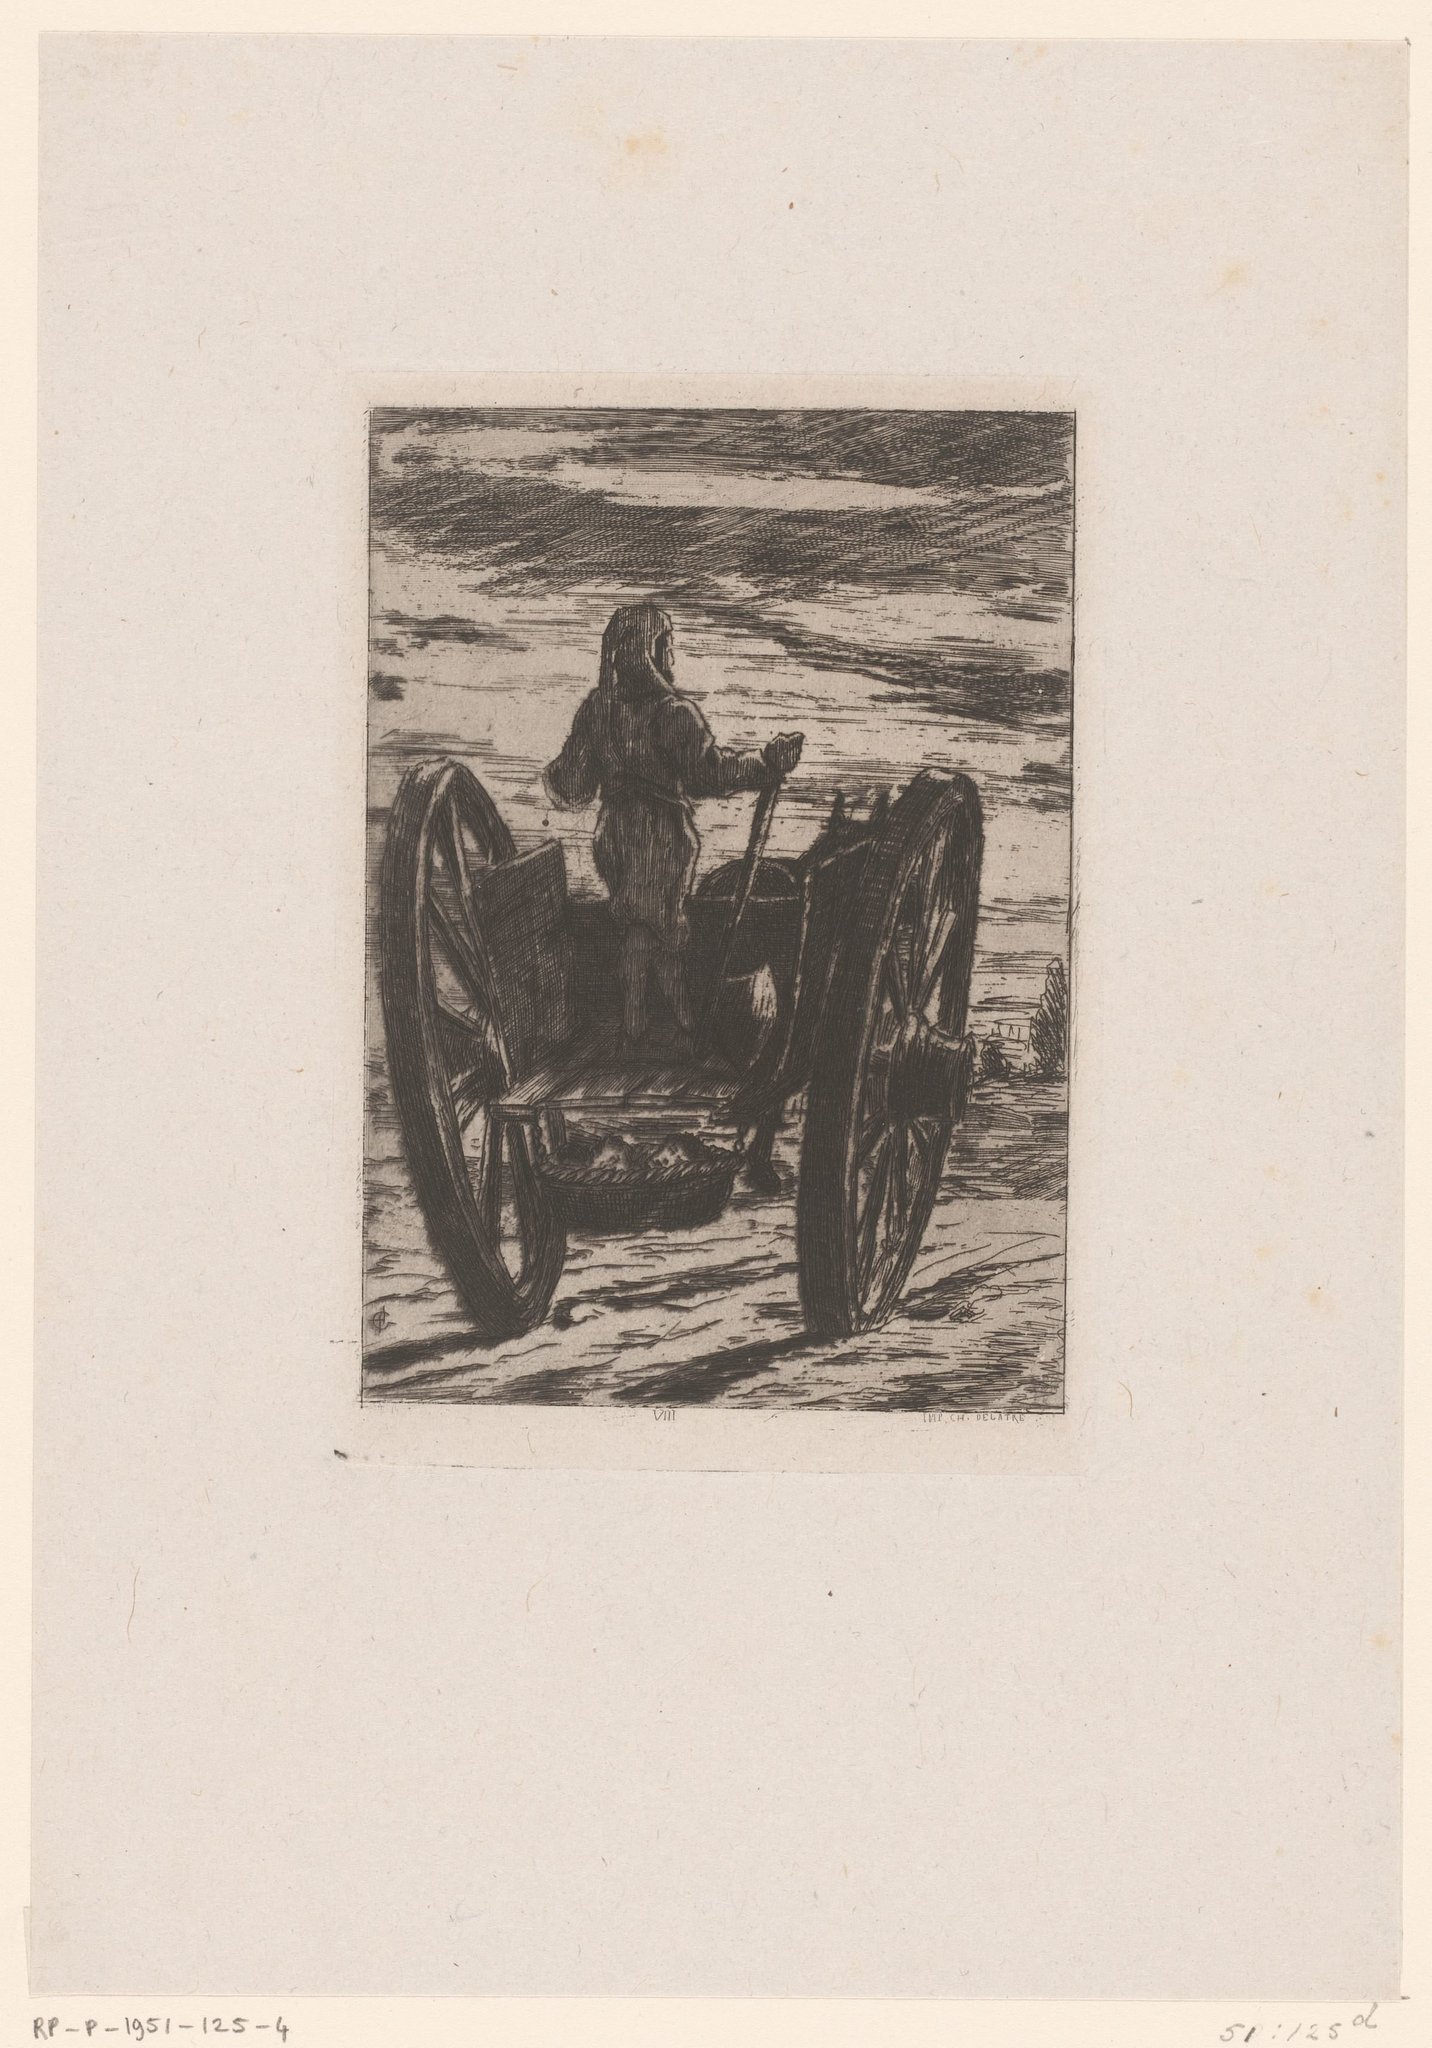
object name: print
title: Beul met zwaard in zijn hand op een kar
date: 1856-1897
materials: paper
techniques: etching, intaglio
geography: paris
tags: illustration ~ printed matter, book, executioner, hangman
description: Maakt deel uit van een tiendelige serie met illustraties bij de dichtbundel 'Les Châtiments' (1853) door Victor Hugo. De tekst werd wegens een anti-napoleontisch sentiment in Frankrijk verboden. Daarom werd de serie in de eerste instantie in Brussel uitgegeven. Deze editie werd echter in Parijs gepubliceerd door de Libraire Nouvelle. Op de achterzijde van de papieren omslag wordt reclame gemaakt voor een serie eveneens door Guérard met illustraties bij 'Napoléon le Petit' door Victor Hugo. De prent illustreert enkele regels uit het gedicht 'Aux Femmes'. Op het opzetvel is betreffende passage geplakt.